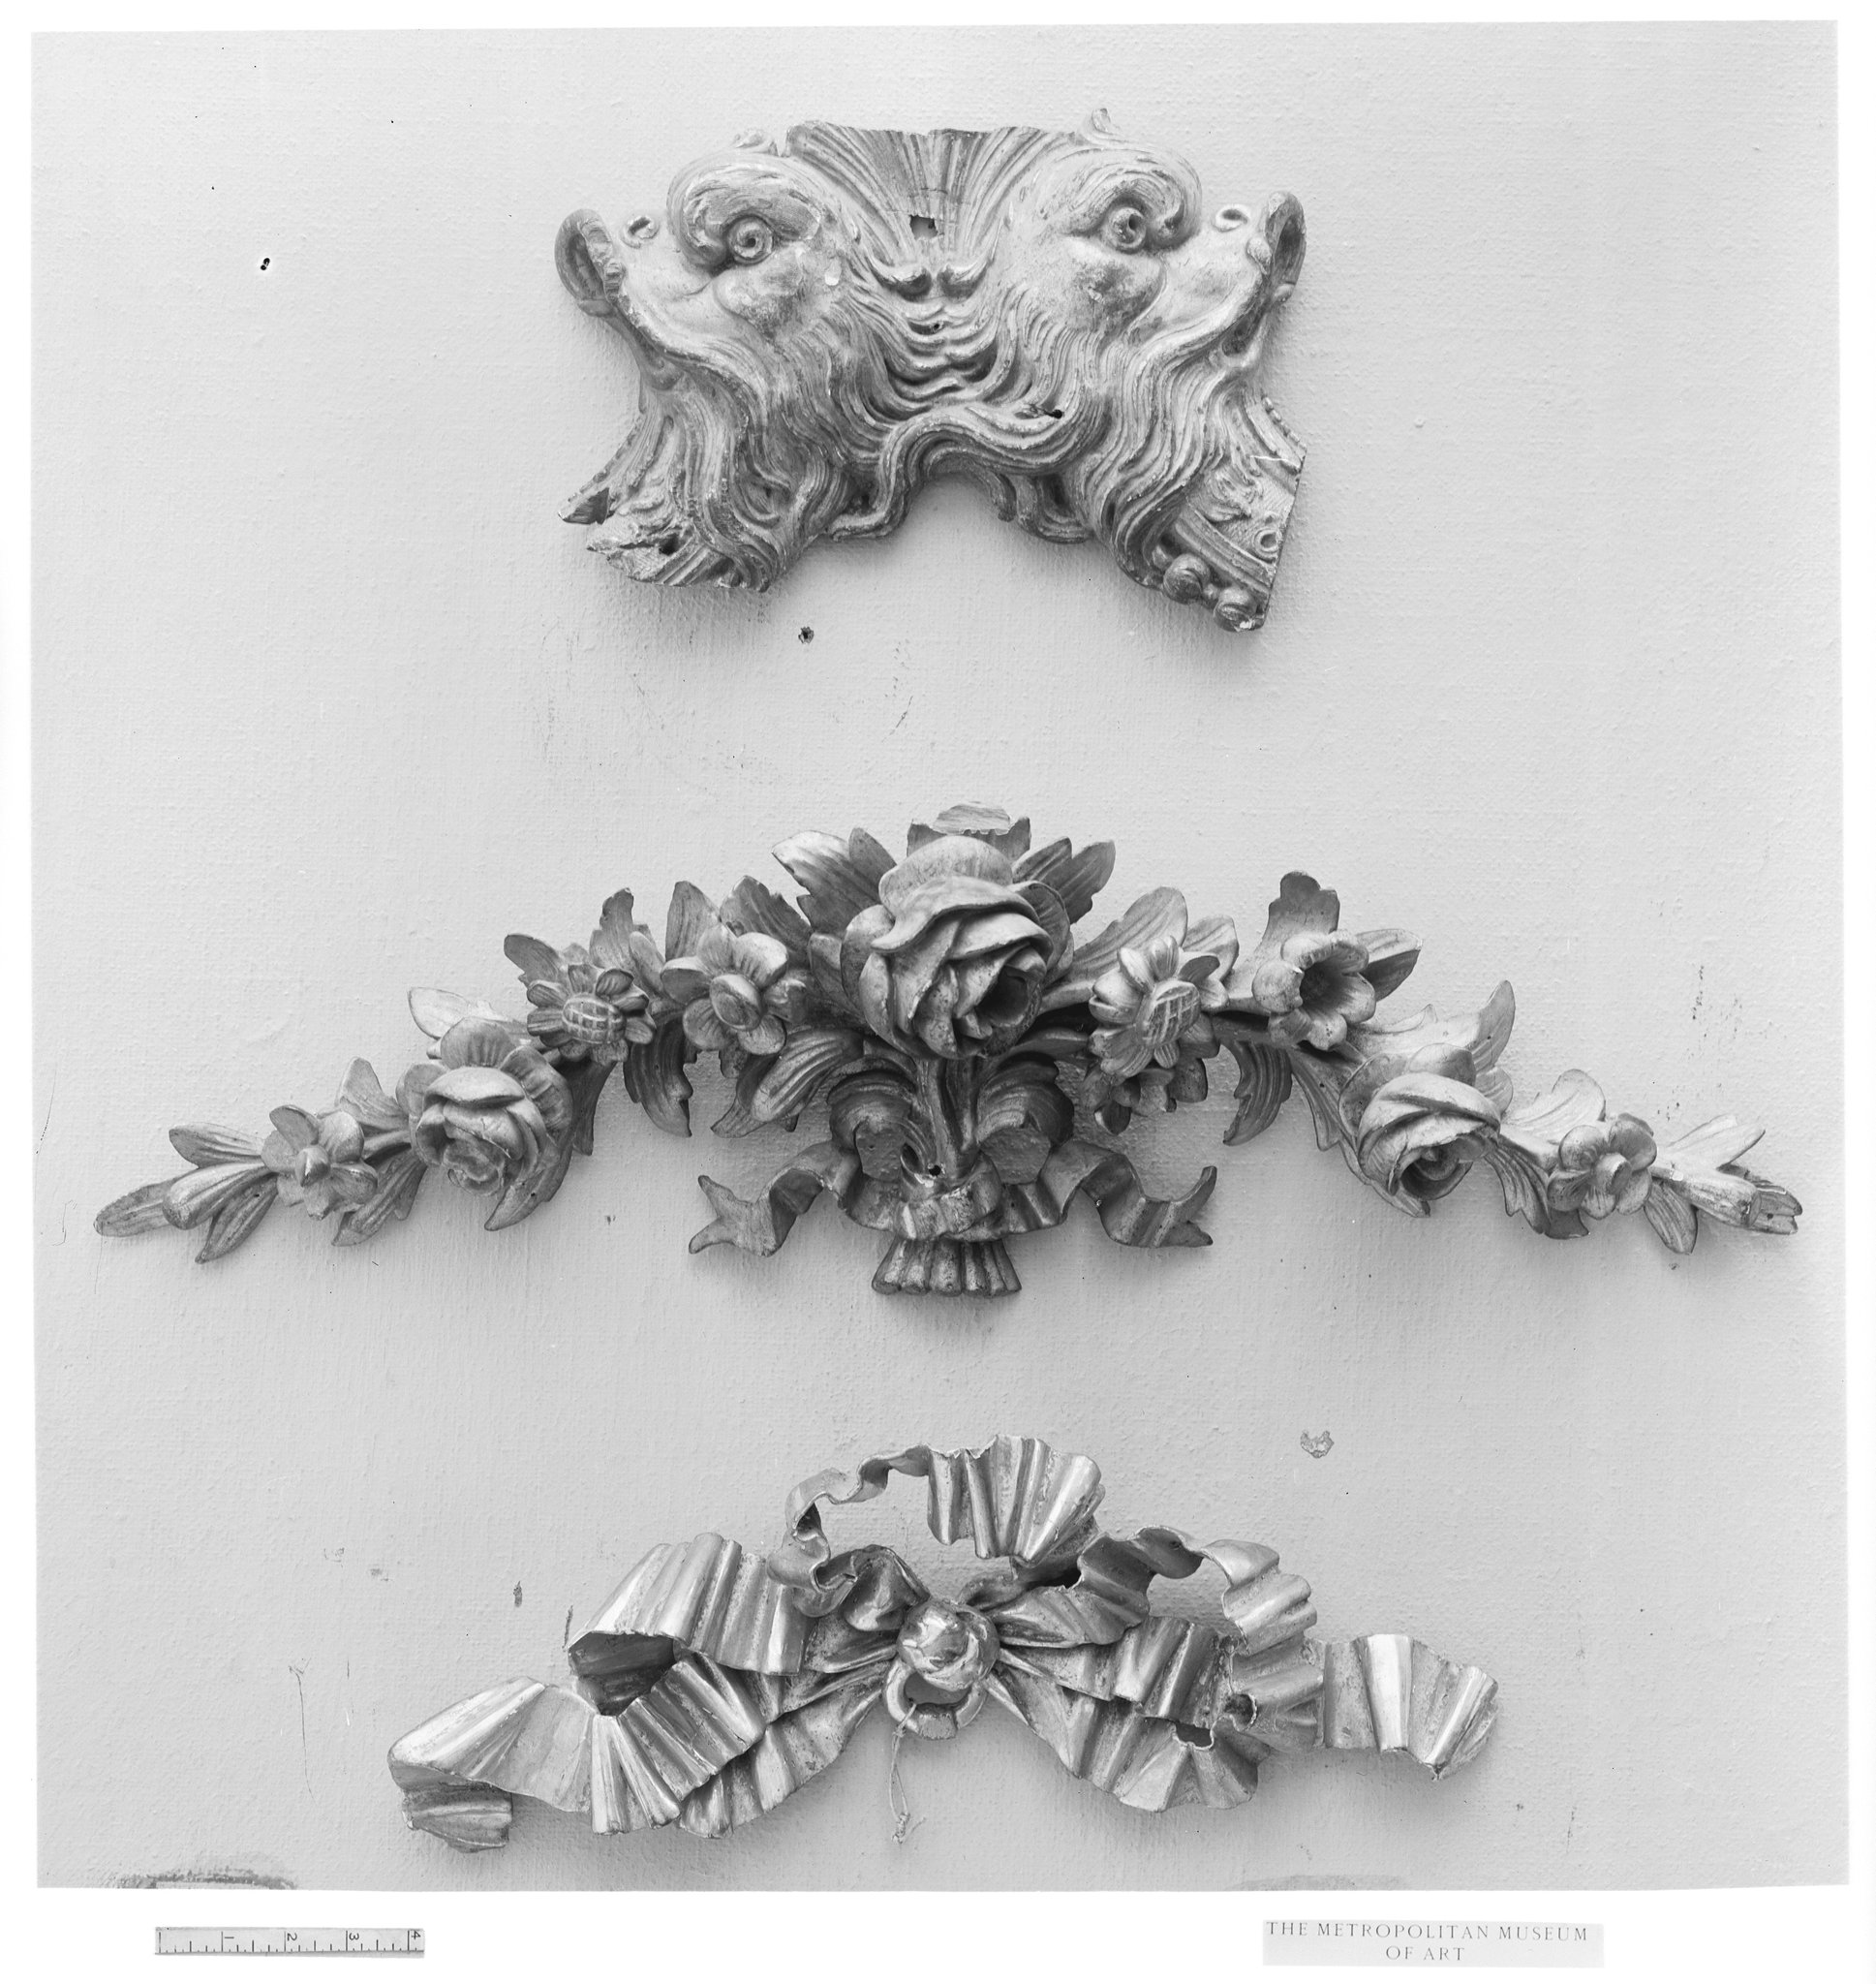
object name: frame ornament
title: Ornament from the top of a frame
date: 1701-1800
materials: gilt, wood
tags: flowers,leaves